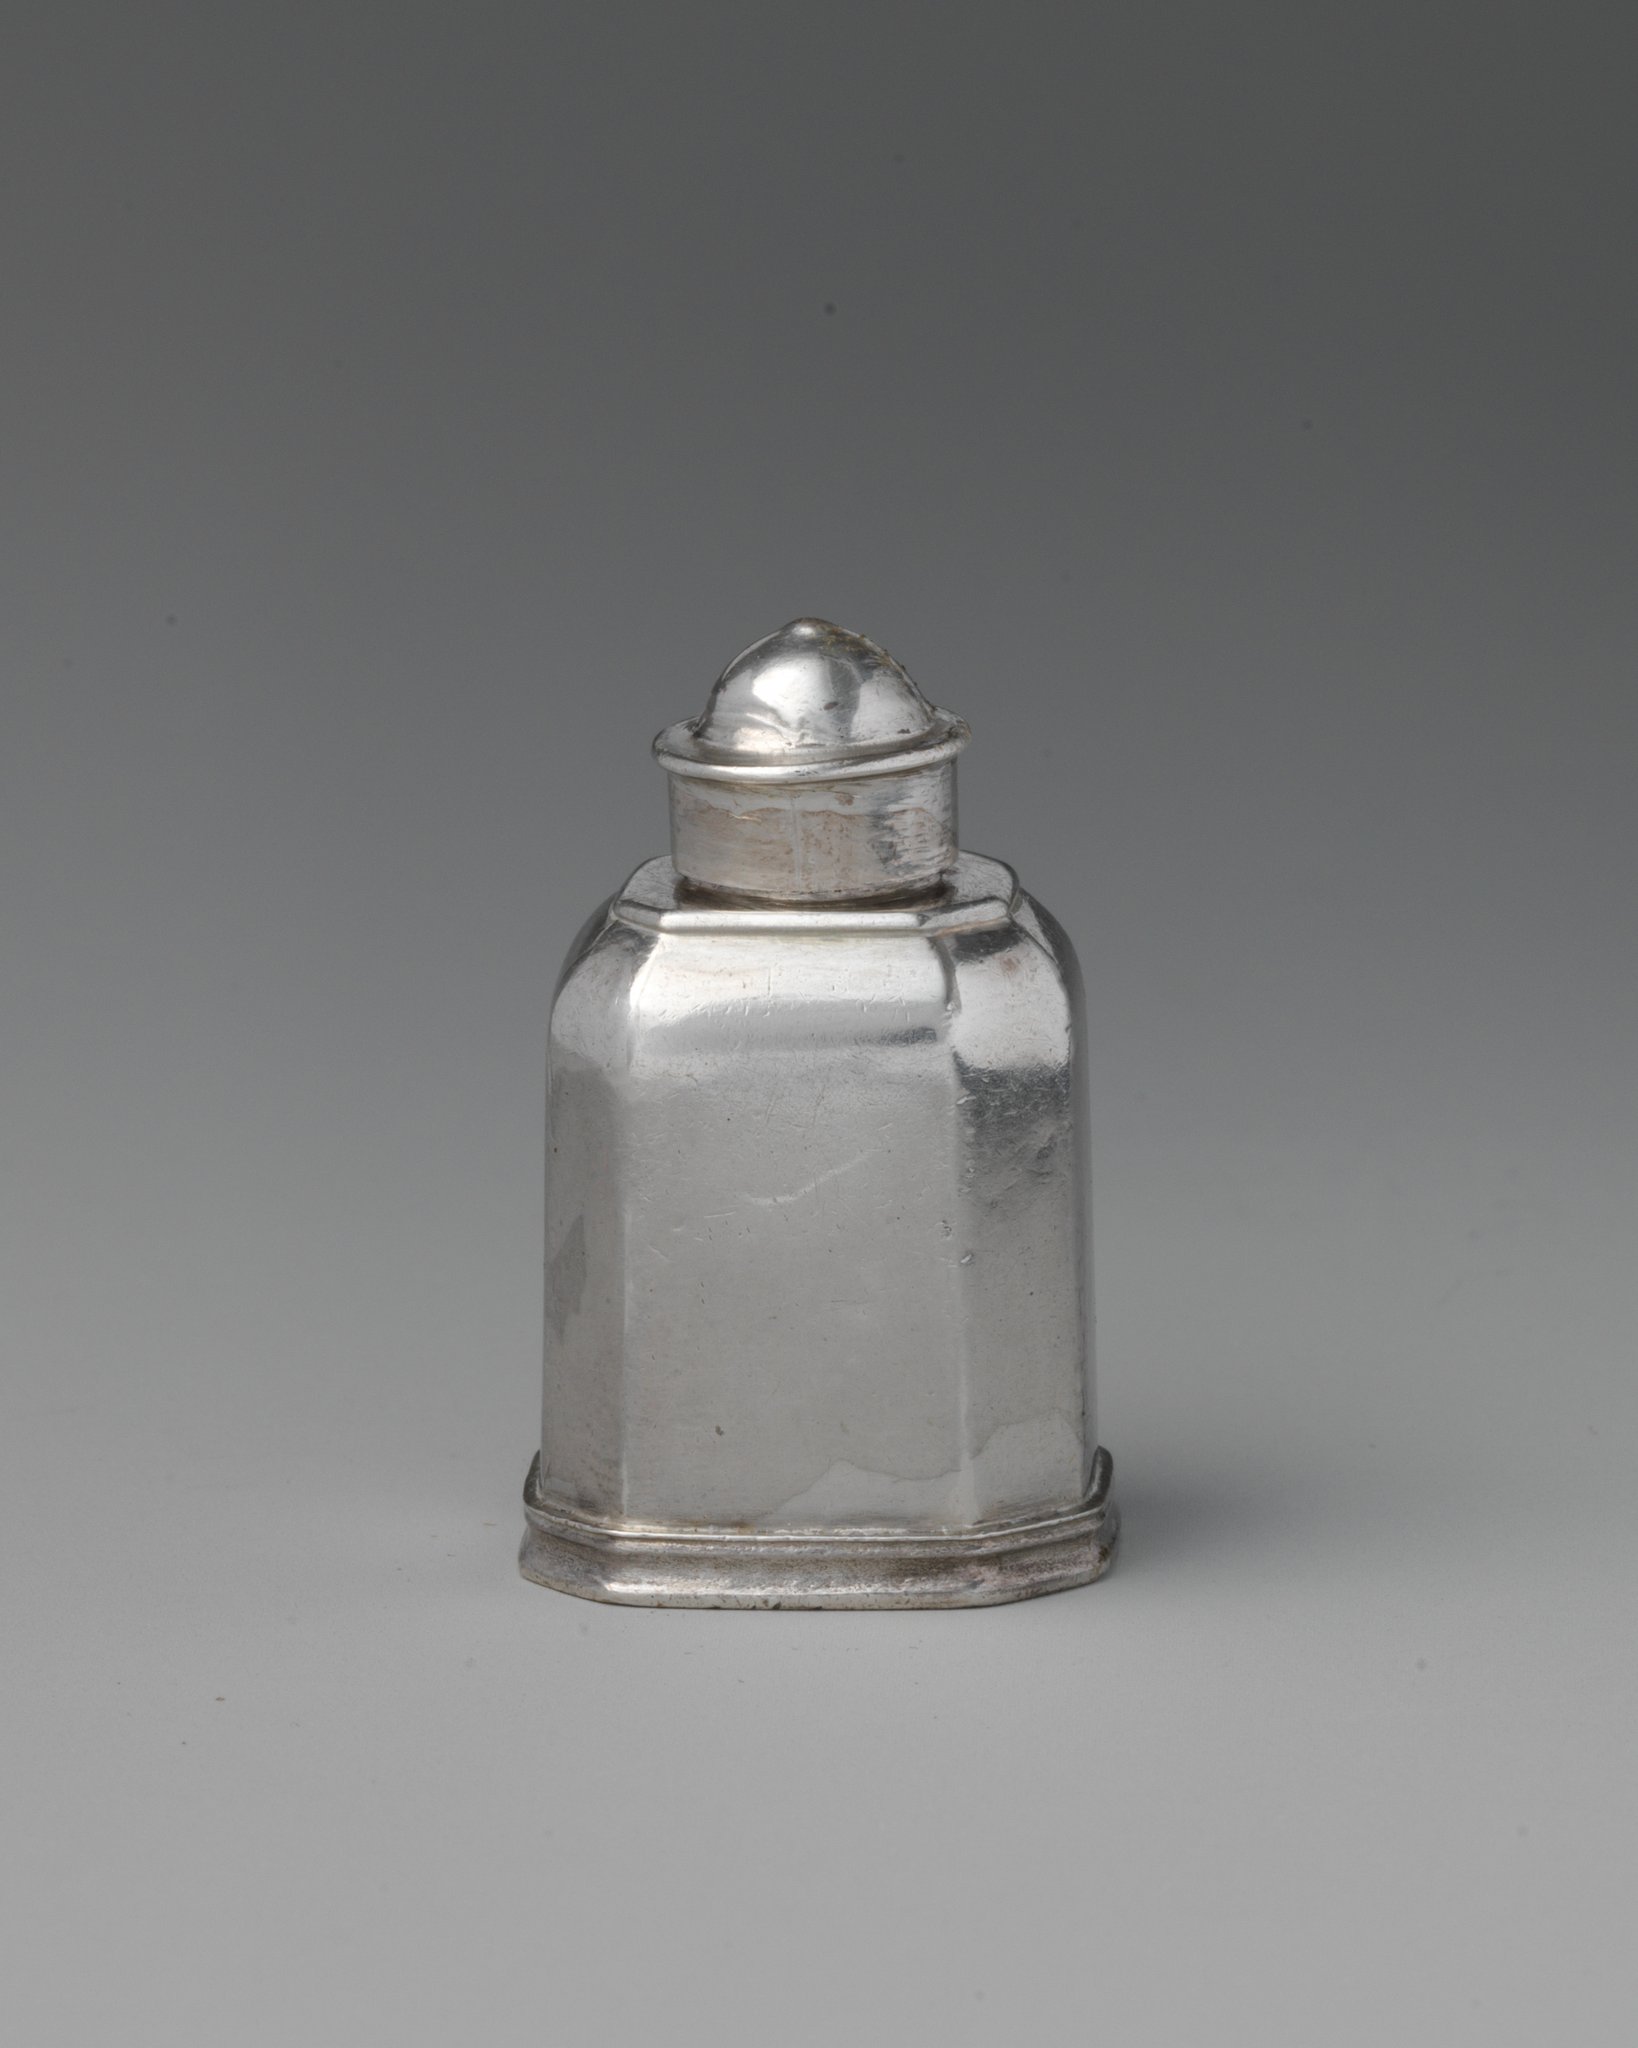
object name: tea caddy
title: Miniature tea caddy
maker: david clayton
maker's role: artist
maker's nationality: british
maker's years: 1659-1719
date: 1720-1730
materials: silver